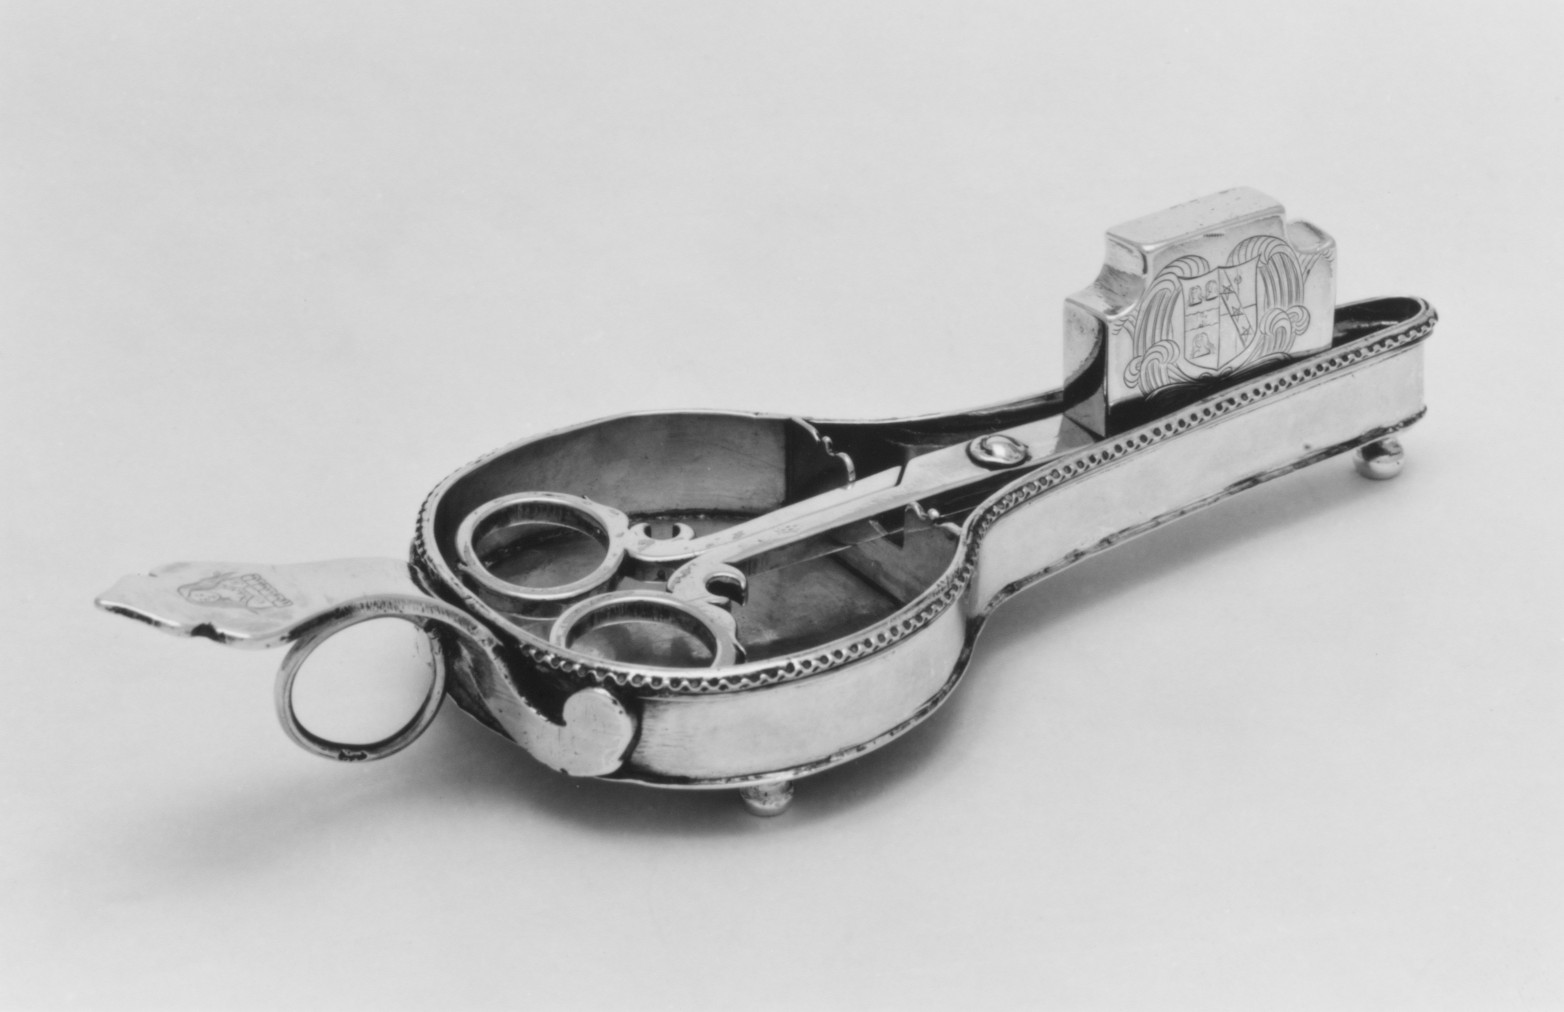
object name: snuffer tray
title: Snuffers and tray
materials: silver